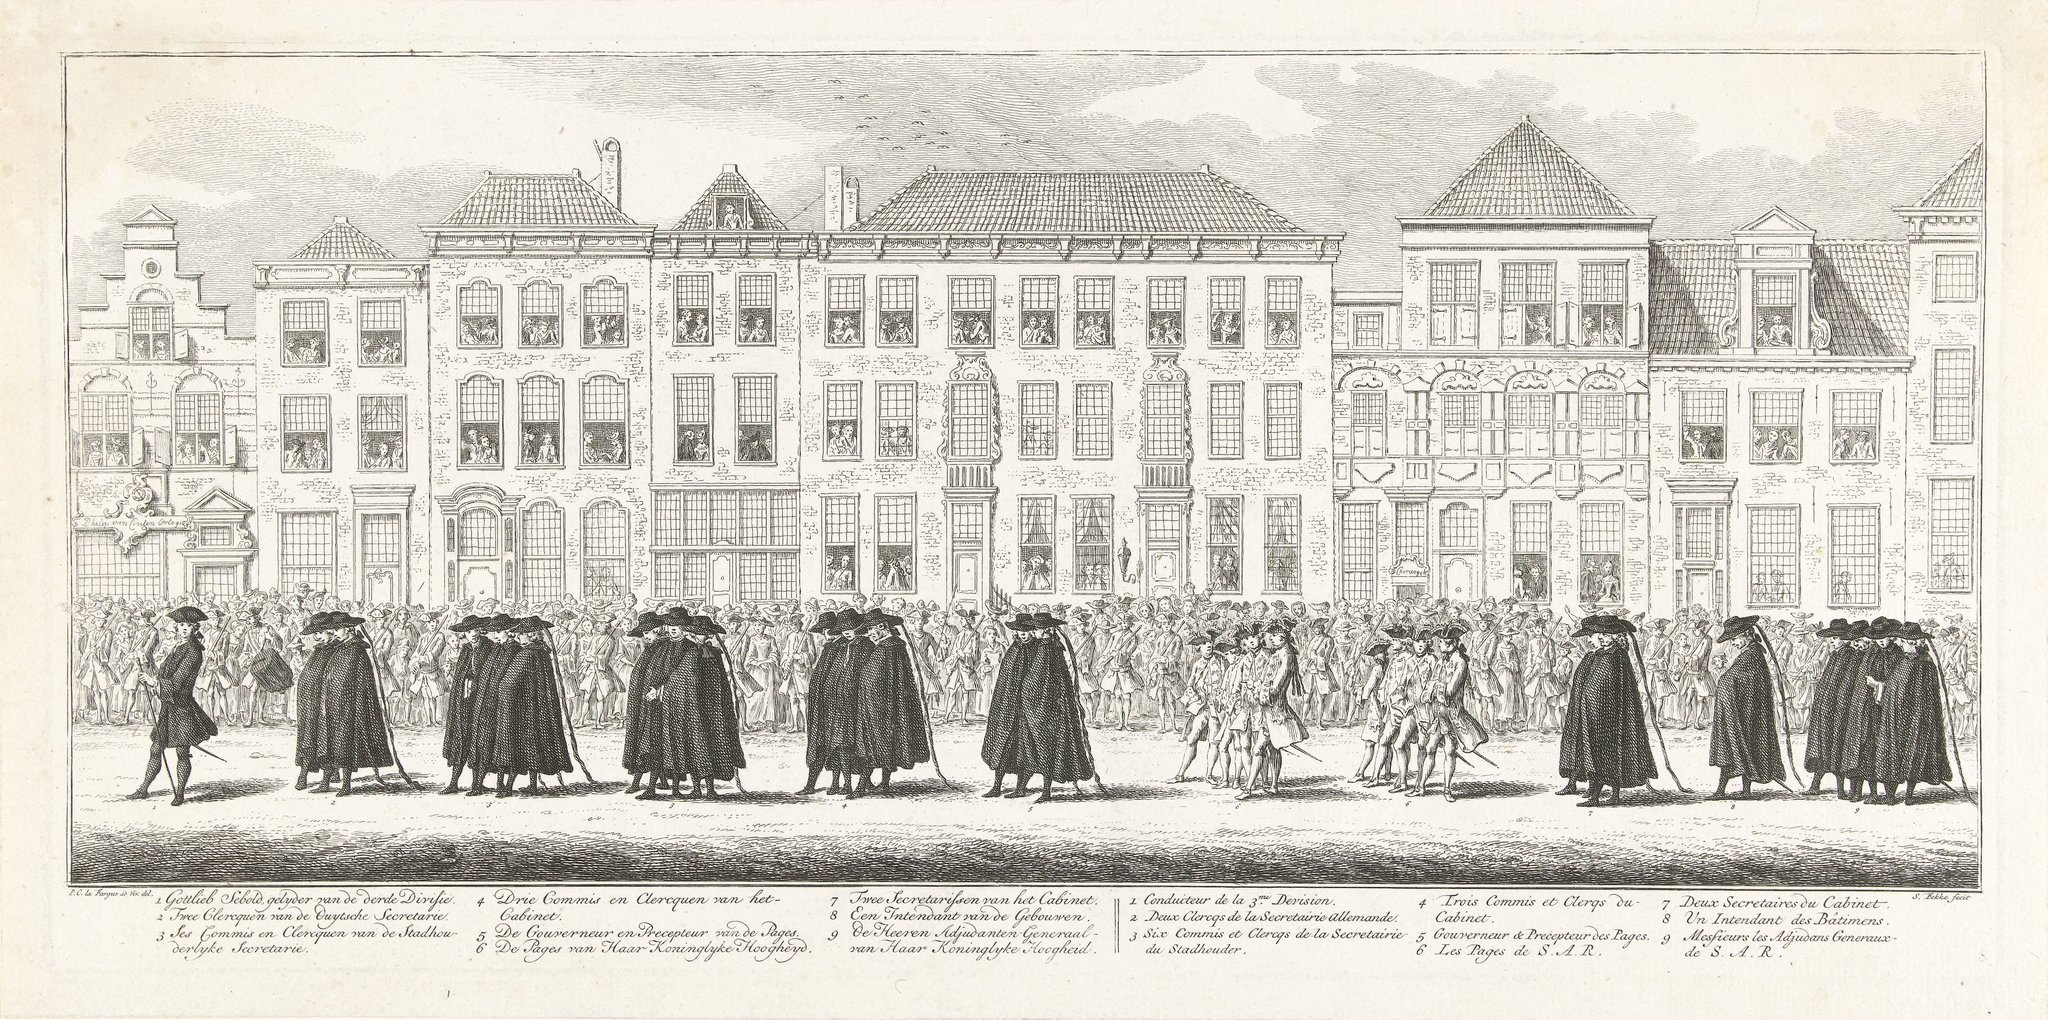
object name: print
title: Lijkstatie van prinses Anna, 1759, plaat 8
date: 1759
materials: paper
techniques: engraving, etching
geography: northern netherlands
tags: anna van hannover, cortege, funeral procession, delft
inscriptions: collector's mark: Lugt 2228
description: Leden van de hofhouding van de prinses. Onderdeel van een serie van 16 platen plus een gedrukte beschrijving van de lijkstatie van de op 23 februari 1759 te Delft begraven prinses Anna van Hannover. Genummerd rechtsonder: 8.